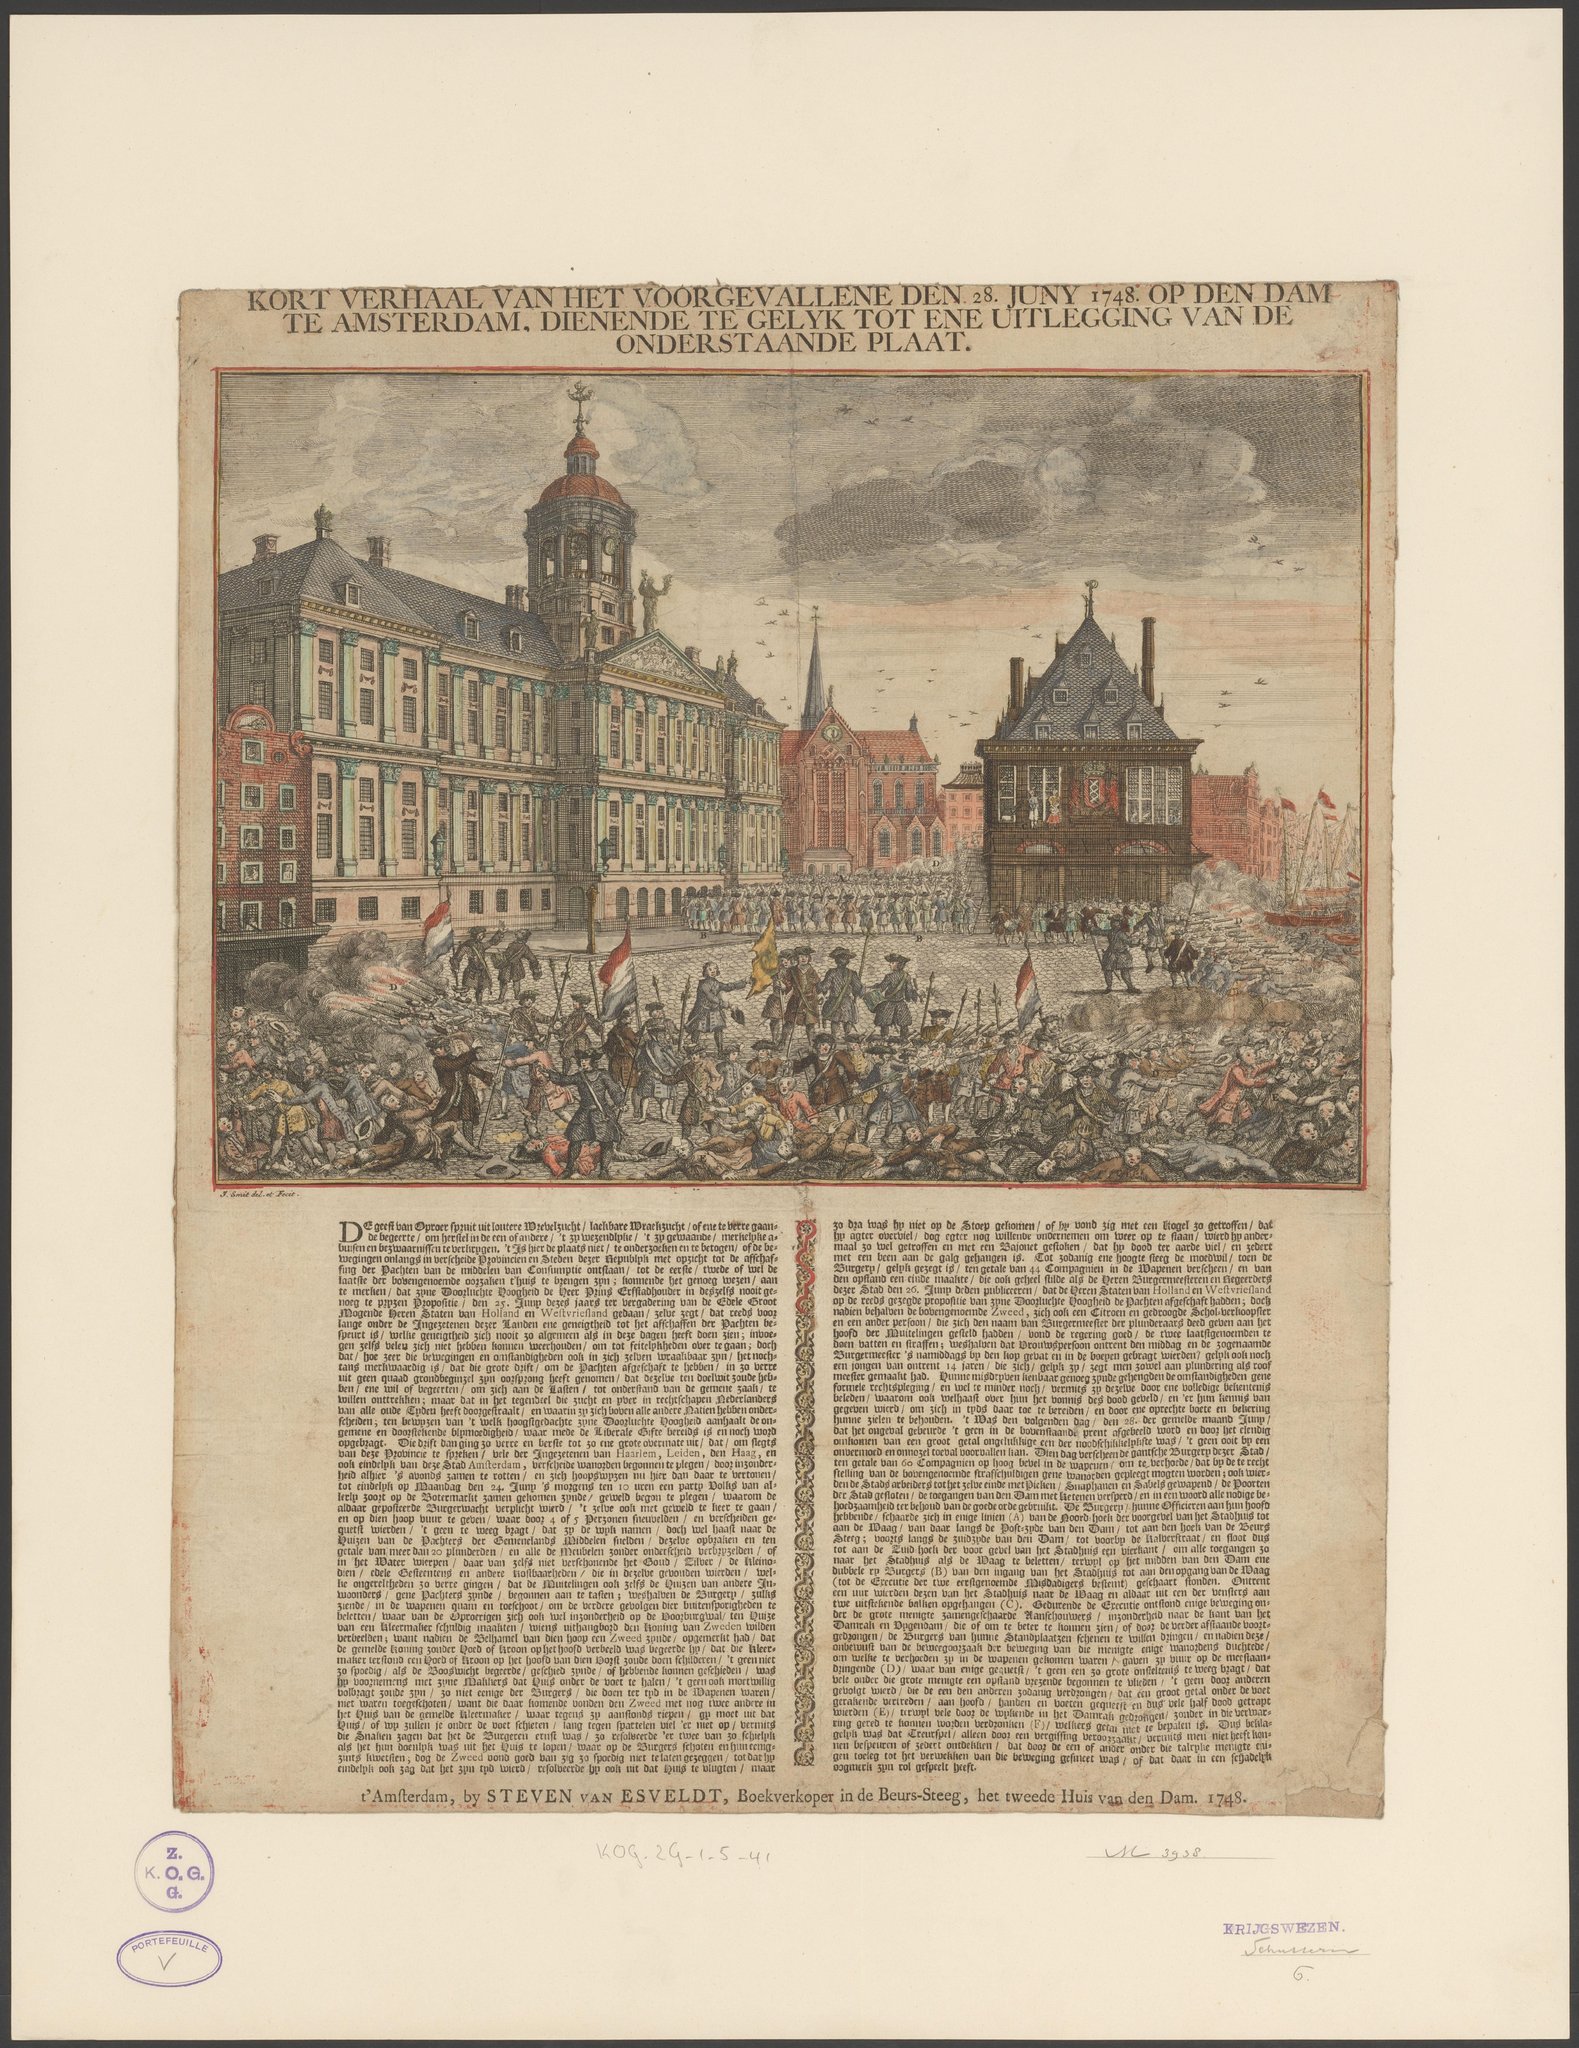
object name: print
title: Kort verhaal van het voorgevallene den 28 juny 1748 op den Dam te Amsterdam, dienende te gelyk tot ene uitlegging van de onderstaande plaat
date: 1748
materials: paper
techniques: etching, hand coloring, letterpress printing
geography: amsterdam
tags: amsterdam, violent death by hanging, street-fights, riots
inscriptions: collector's mark: Lugt 1641, stamp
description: Gezicht op de Dam met het stadhuis, de Nieuwe Kerk, de Waag en het Damrak, met het schieten door de burgerwacht in de rijen van de opdringende toeschouwers op de Dam, 28 juni 1748. Aan de Waag hangen de lichamen van de terechtgestelde man en een vrouw (Piet van Dort en de citroen- en gedroogde scholverkoopster Mat van den Nieuwendijk) wegens hun rol in het Pachtersoproer. Op het blad onder de plaat een beschrijving van de gebeurtenissen in twee kolommen. Onderwerpsrubrieken binnen de Atlas Zeden en Gewoonten: Krijgswezen, Schutterij, Historieprenten.